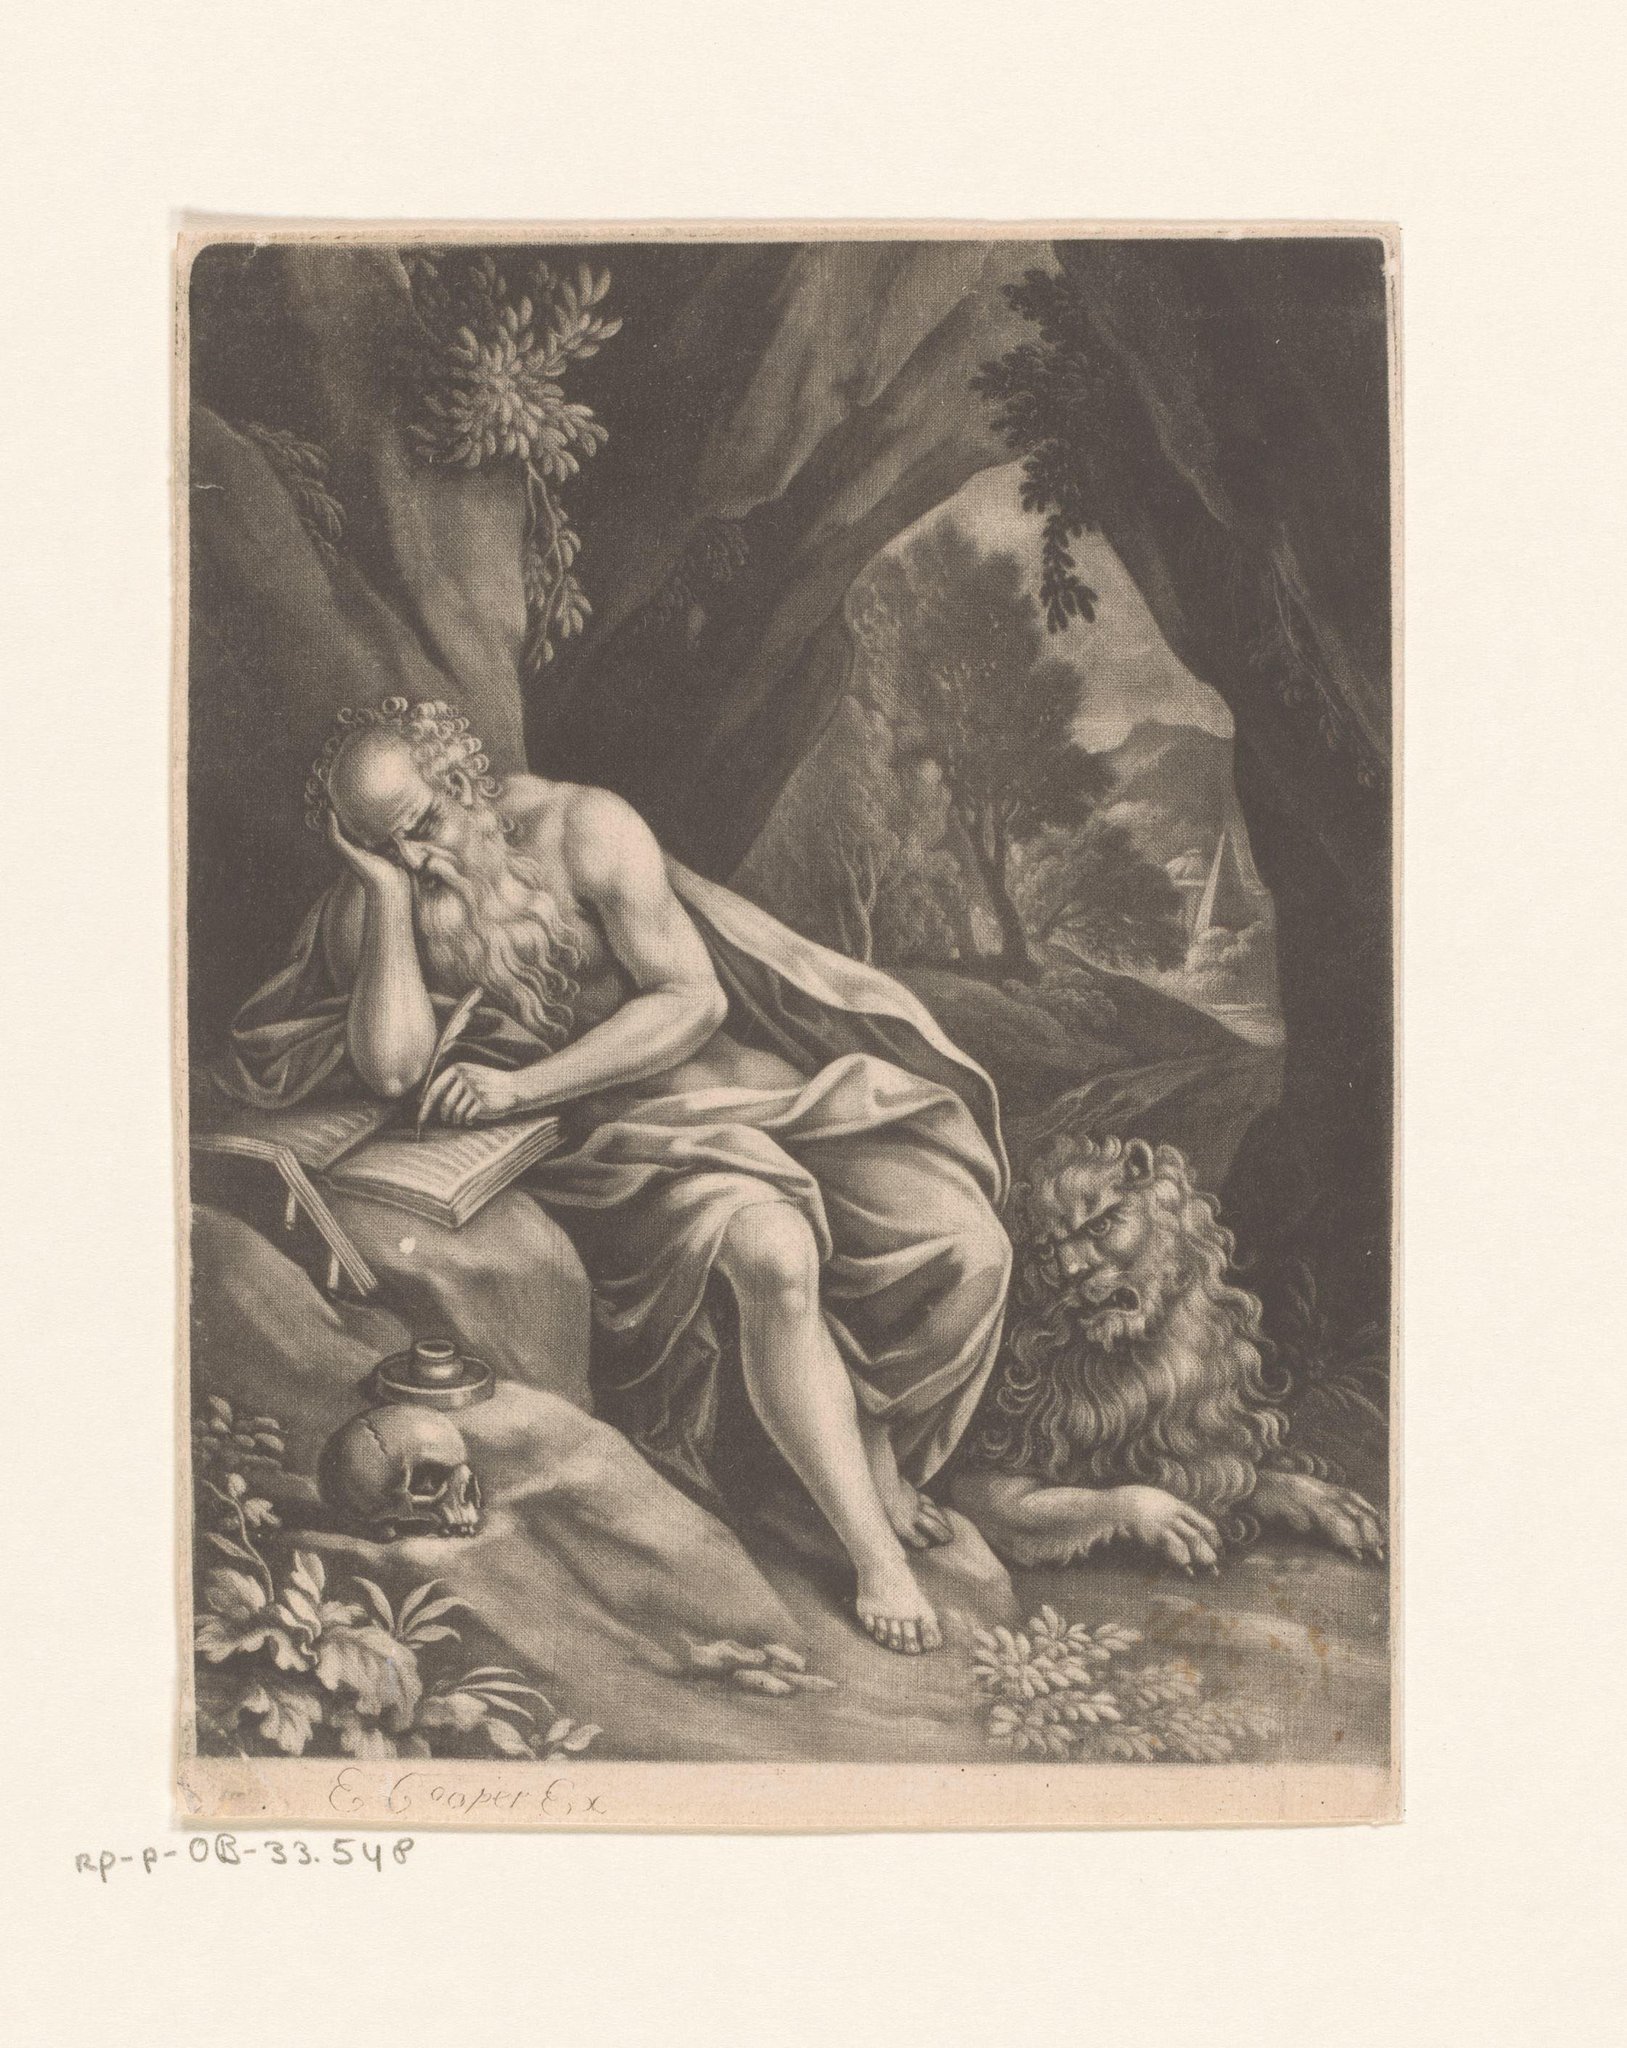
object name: print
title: Heilige Hieronymus in de wildernis, schrijvend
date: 1682-1725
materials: paper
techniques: mezzotint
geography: london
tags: st. jerome as hermit in a landscape, reading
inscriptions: collector's mark: Lugt 240